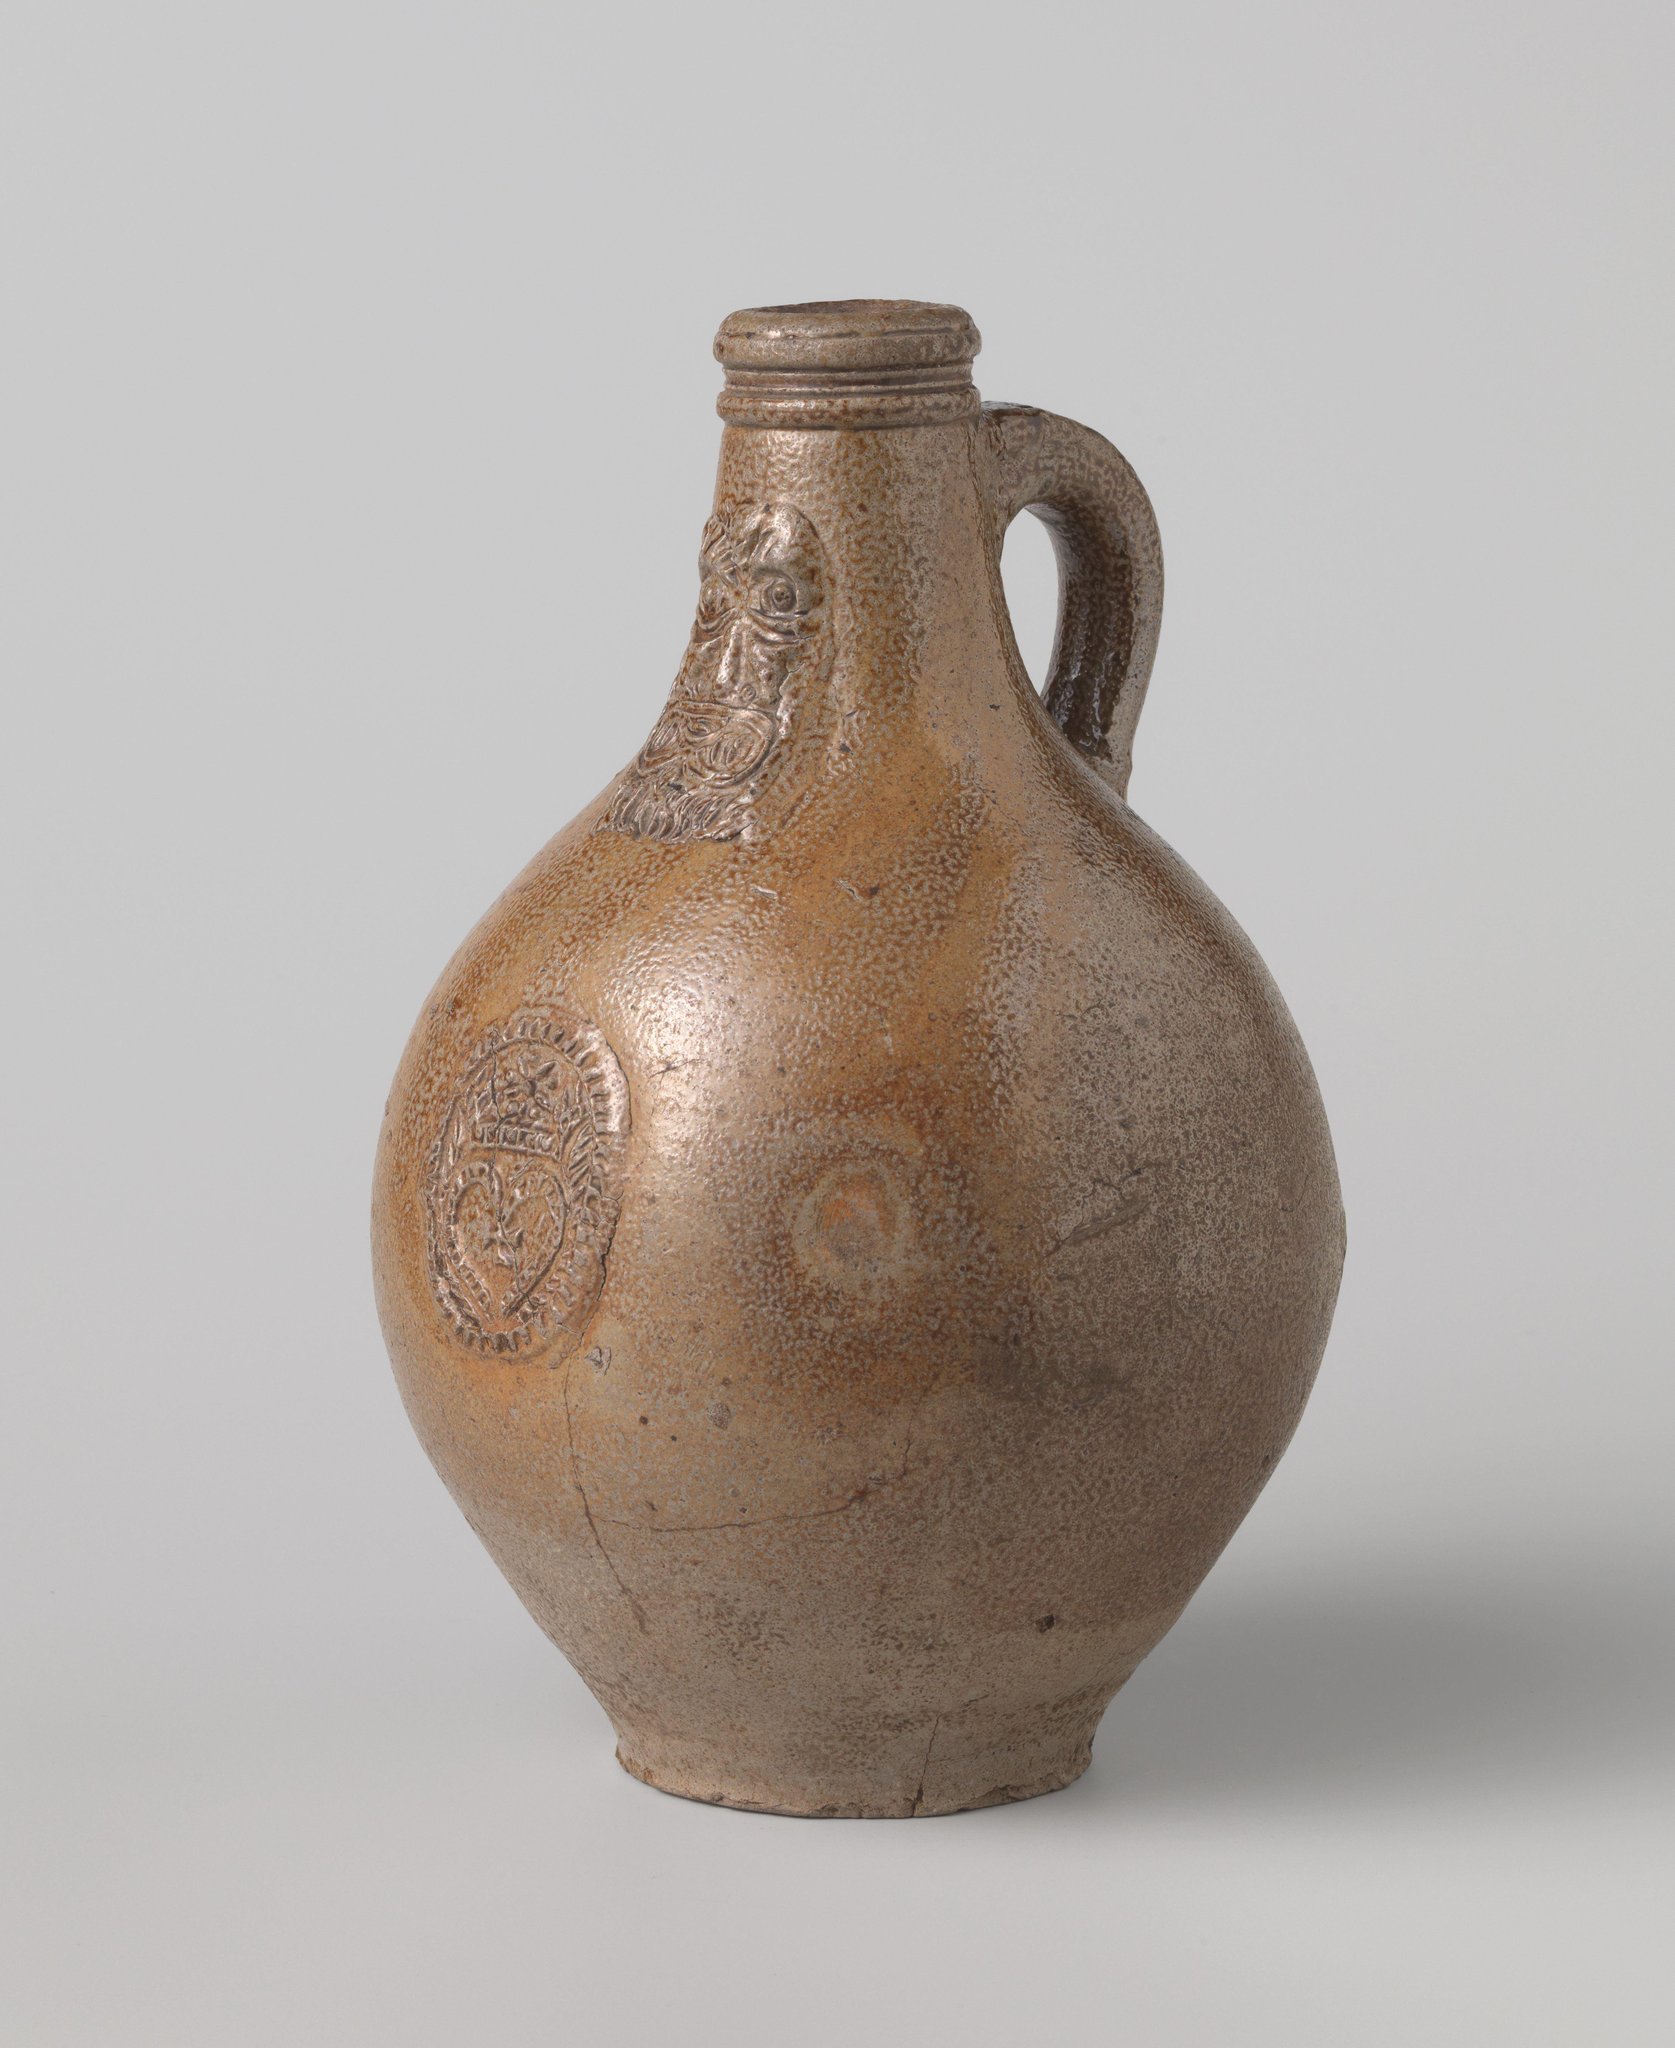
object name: jug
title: Jug (Bartmann jug) with a crowned heart in a medallion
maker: Anonymous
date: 1600-1749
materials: engobe, glaze, stoneware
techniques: firing, forming, relief, turning, vitrification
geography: frechen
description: Kruik (baardmankruik) van steengoed op standvlak met een bolvormig lichaam en smalle nek. Het C-vormige oor is bevestigd aan de nek en de schouder. Profielen op de nek. Op de voorzijde van de buik in reliëf een gedrukt en opgelegd medaillon met een gelijkarmig kruis in een gekroond hart. Op de nek, doorlopend op de schouder, een baardman. Frechen.